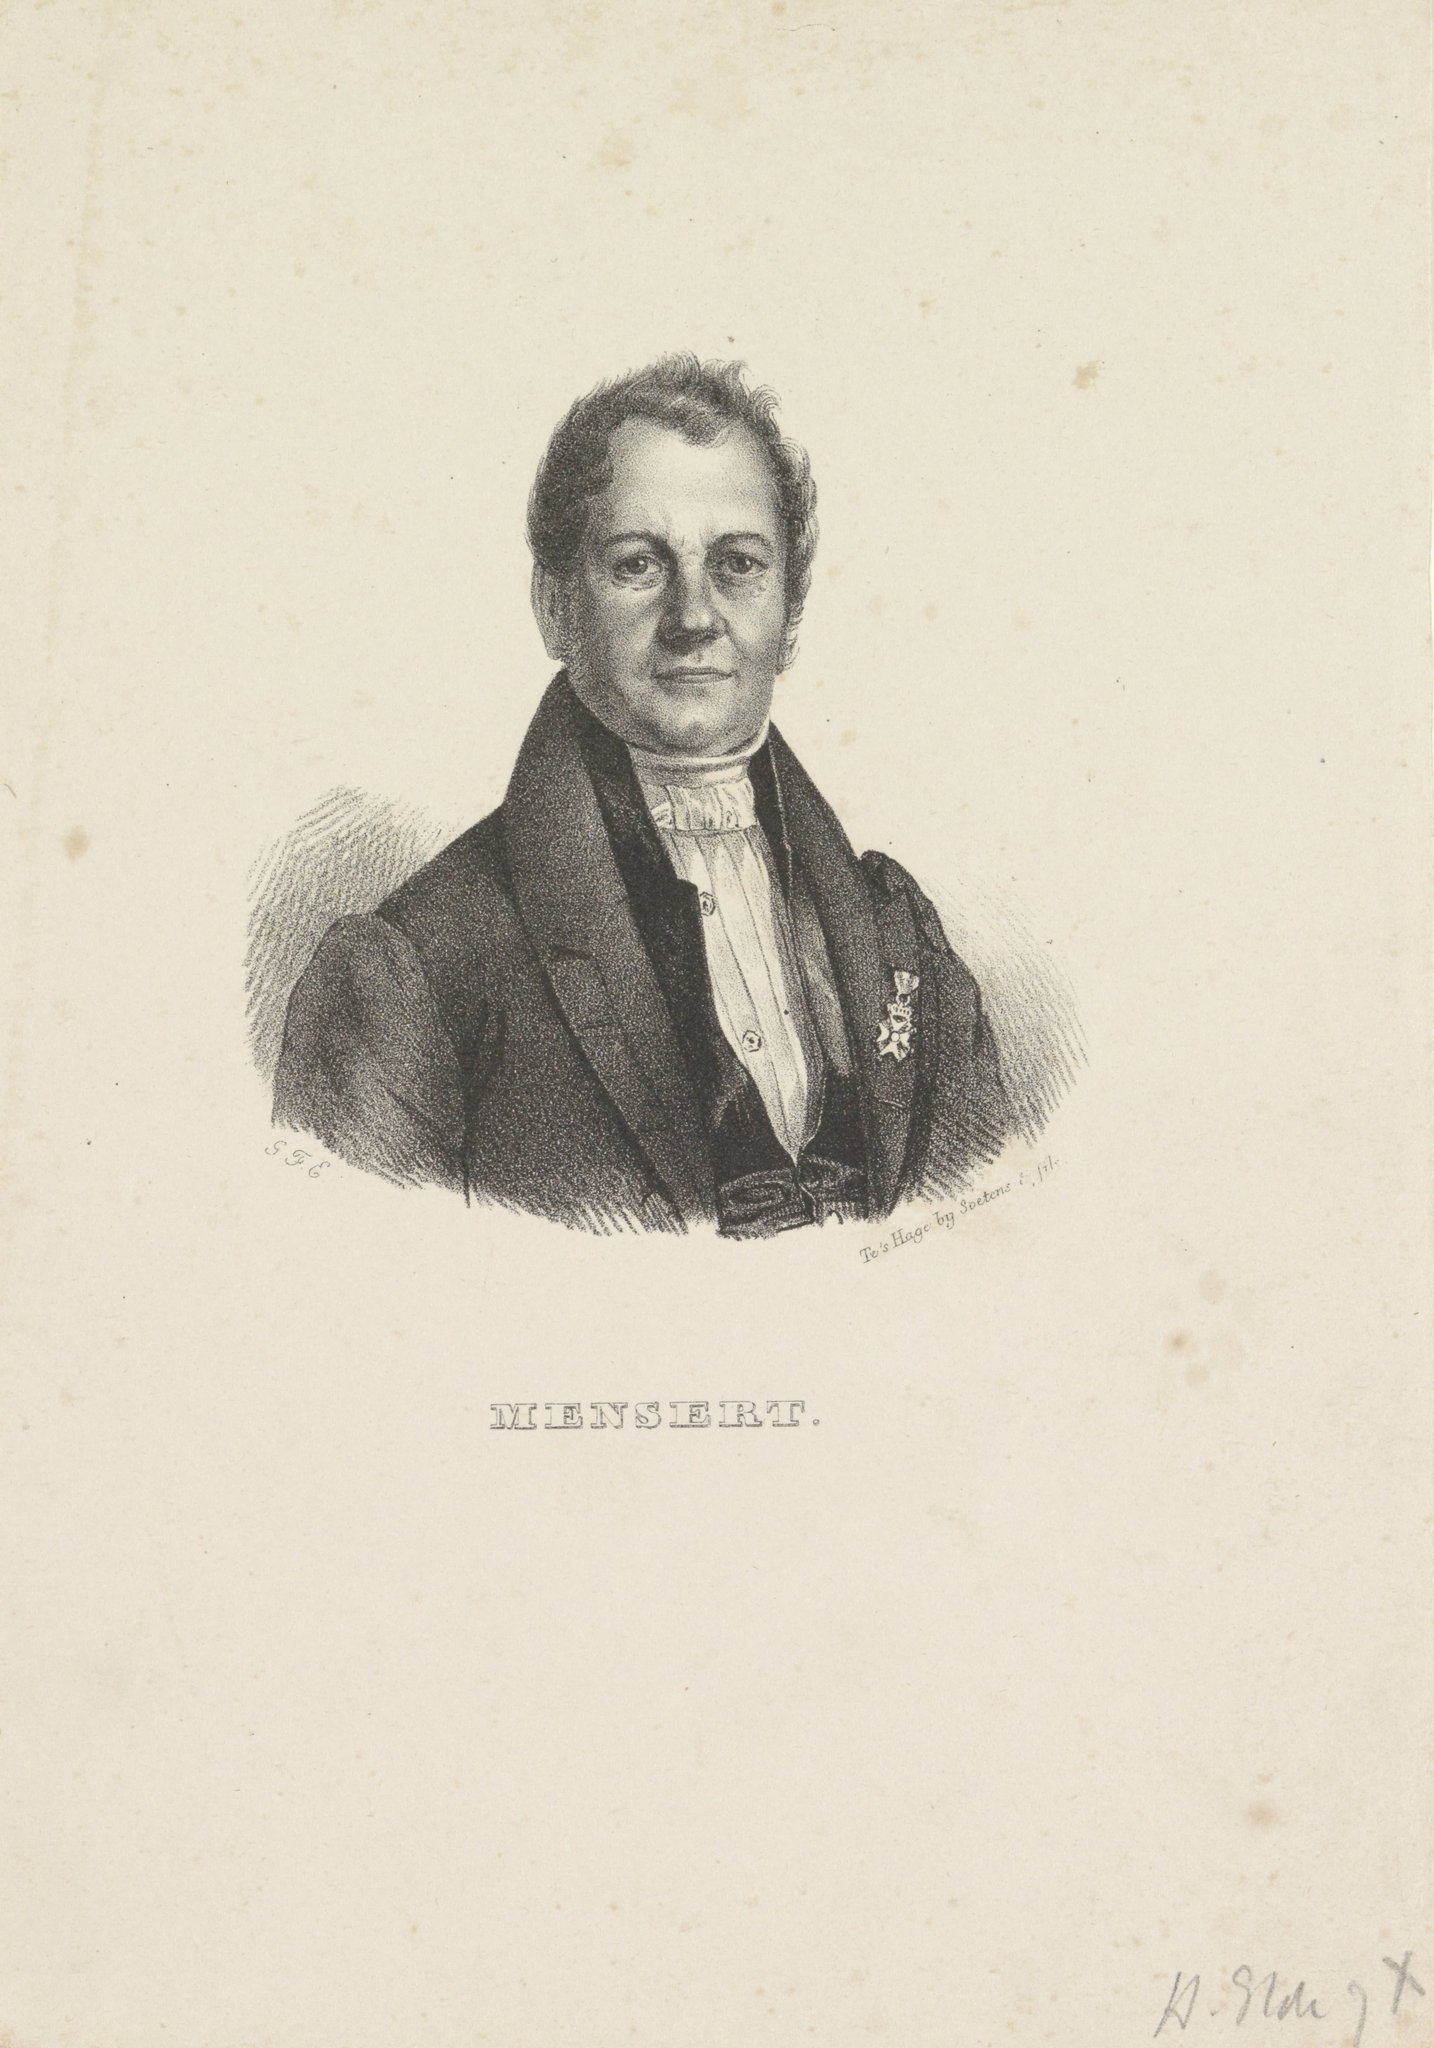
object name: print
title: Portret van W. Mensert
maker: gerhardus fredericus eilbracht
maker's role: draughtsman, print maker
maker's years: 1816-1854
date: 1837-1840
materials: paper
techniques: lithograph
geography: the hague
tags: knighthood order, historical persons (+ (full) bust portrait)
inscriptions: collector's mark: Lugt 2228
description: De geportretteerde draagt een ridderorde op de revers van zijn jas. Onder het portret zijn naam.